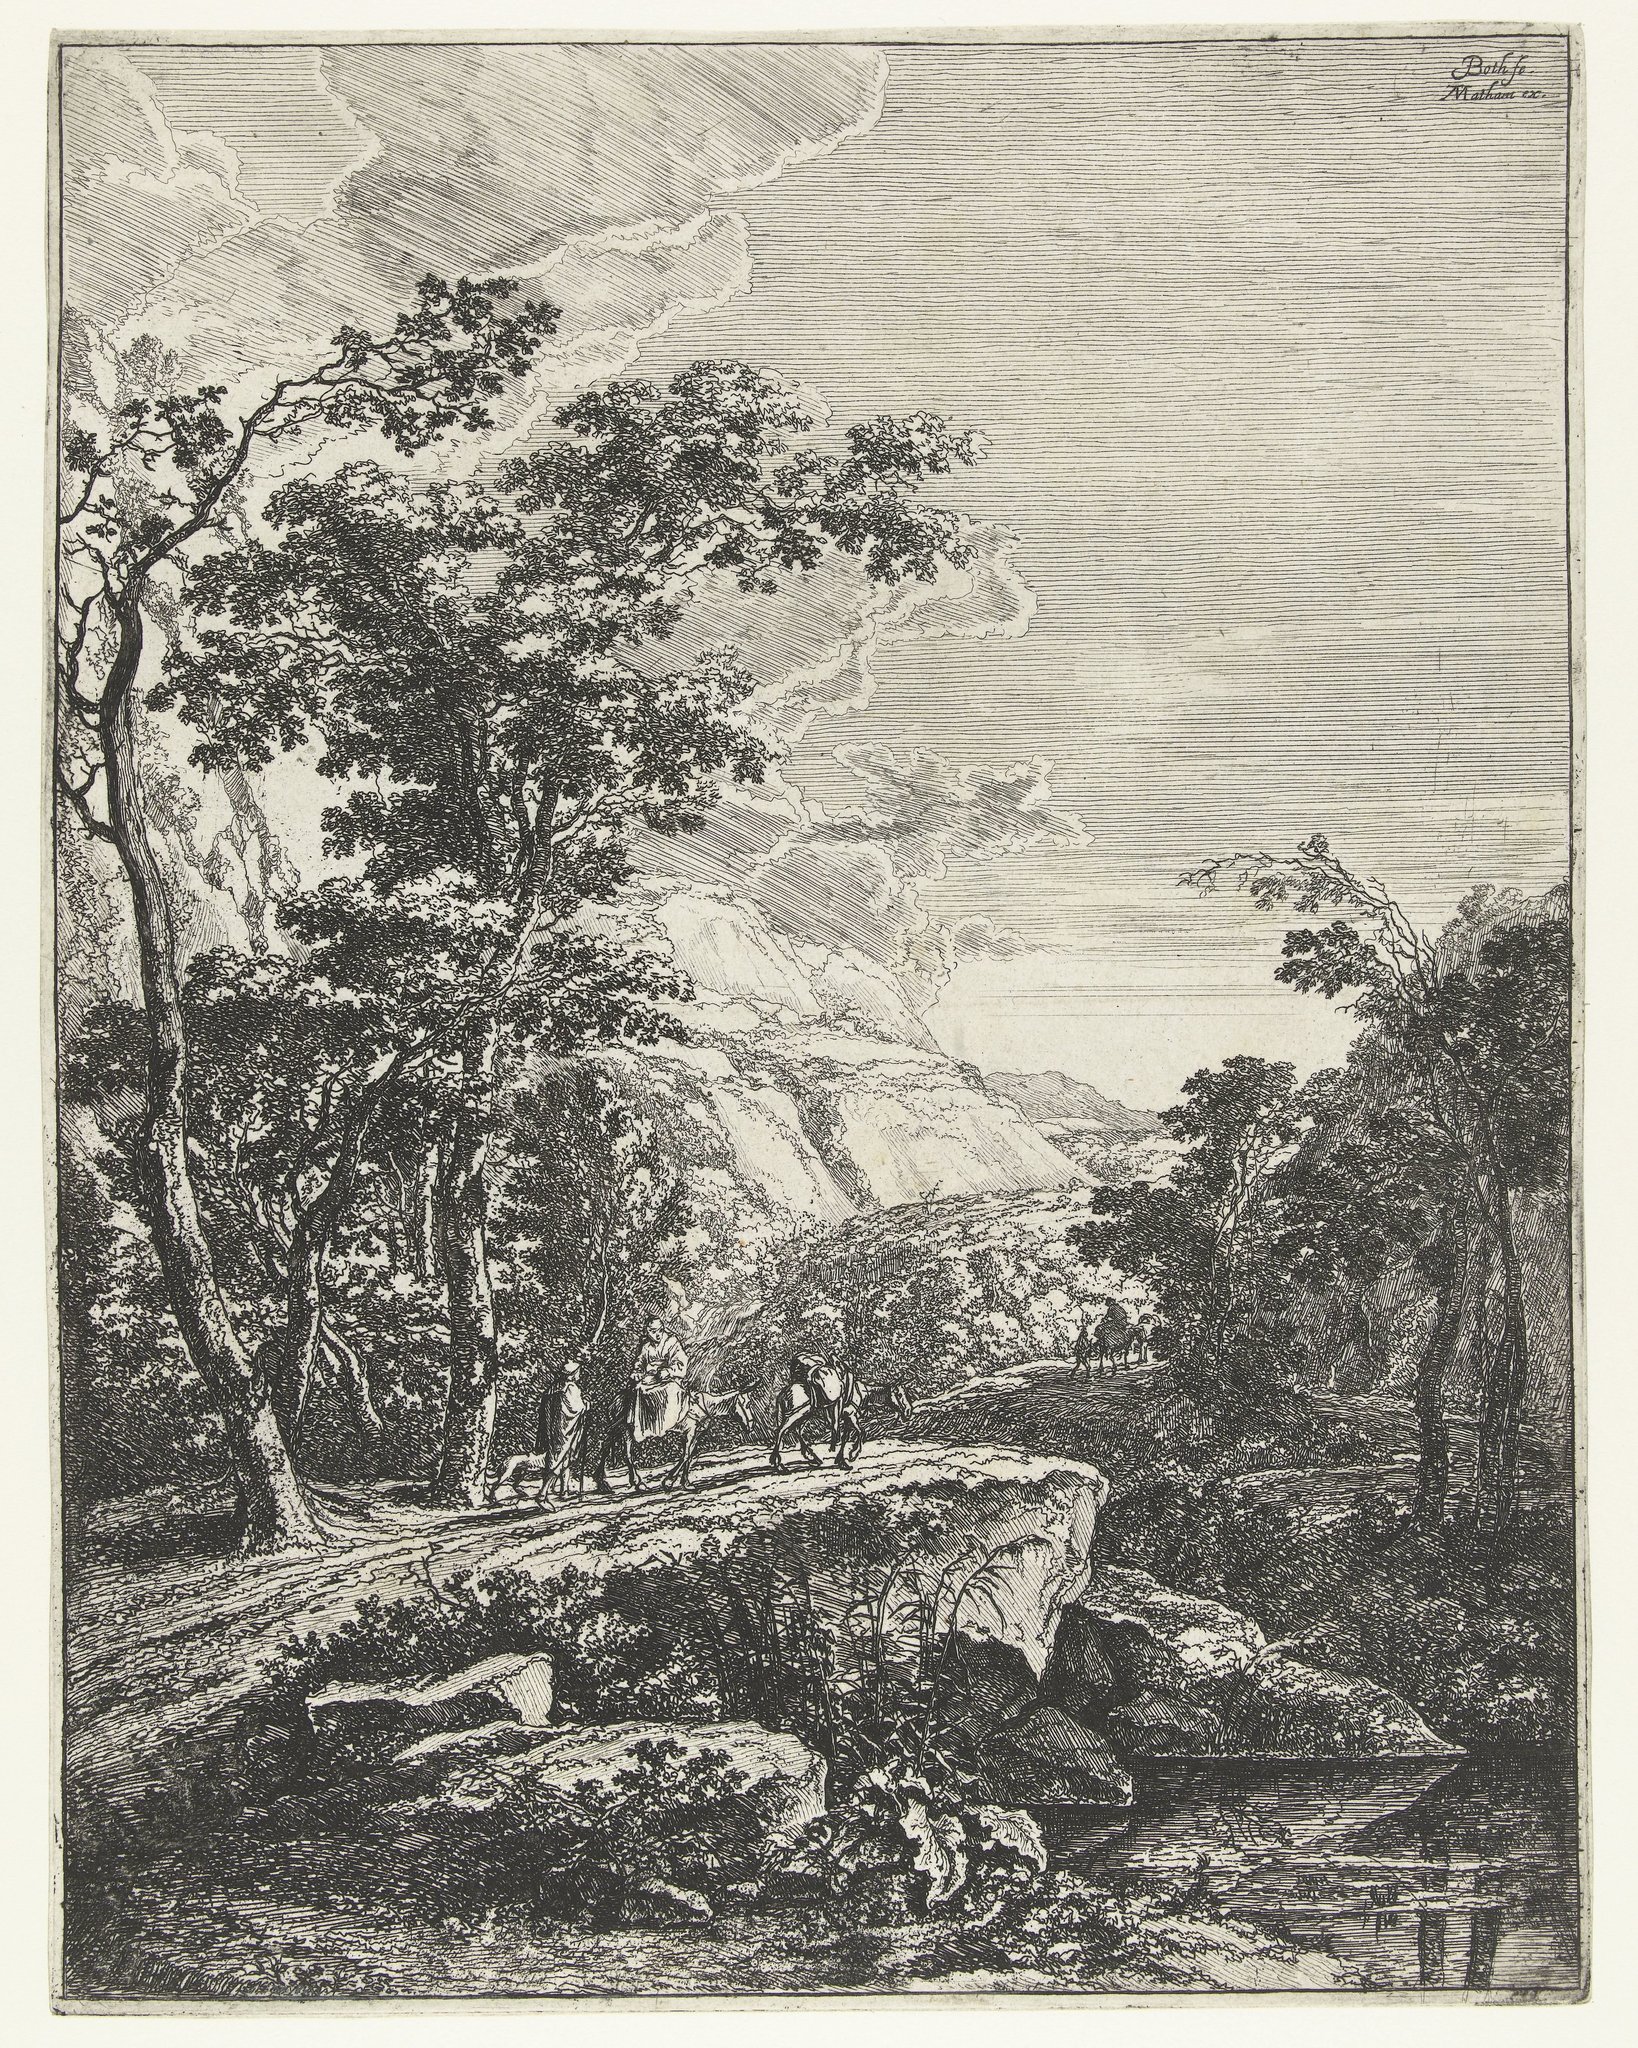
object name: print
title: Landschap met vrouw rijdend op een muilezel langs de Aqua Negro tussen Bologna en Florence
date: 1644-1652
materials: paper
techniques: etching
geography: netherlands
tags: mule, rocks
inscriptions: collector's mark: Lugt 964